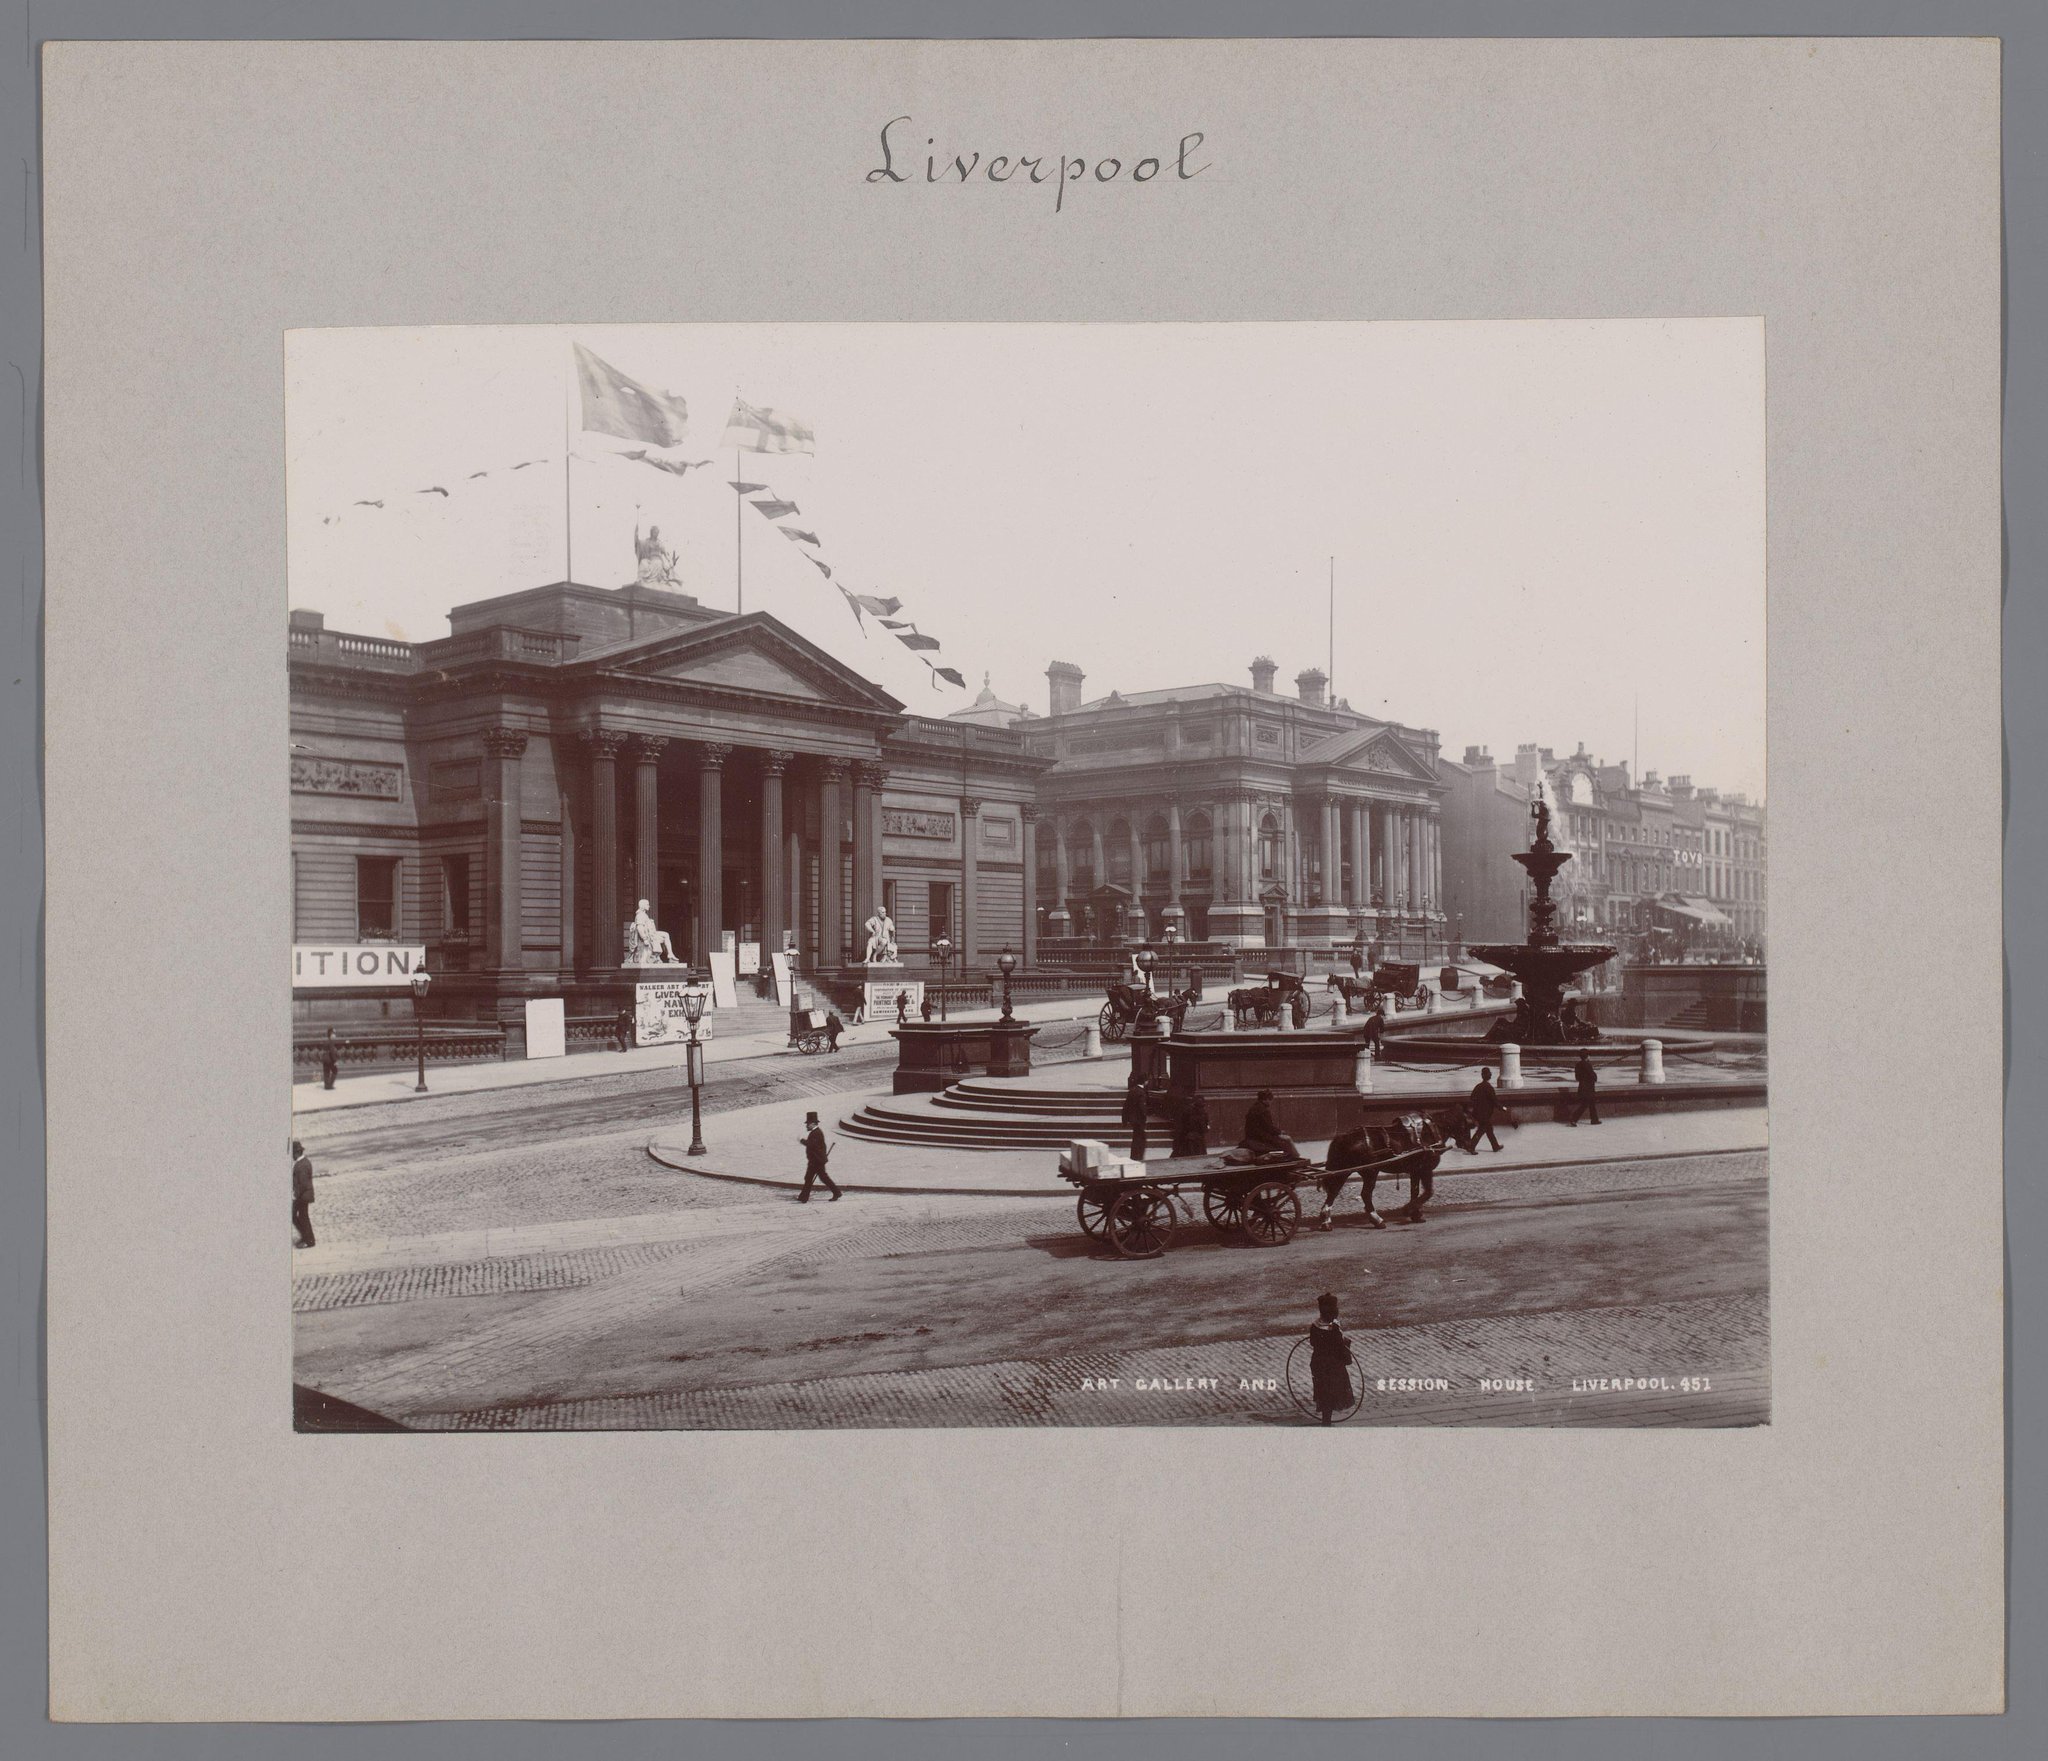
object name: photograph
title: Walker Art Gallery en Session House, William Brown Street, Liverpool, Engeland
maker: Anonymous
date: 1880-1910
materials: cardboard, paper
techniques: collodion silver print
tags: liverpool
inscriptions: inscription: ‘ART GALLERY AND SESSION HOUSE LIVERPOOL. 451’, inscription: ‘Liverpool’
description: Gezicht op een plein met fontein, links voor een classicistisch gebouw (Walker Art Gallery), daarnaast, meer rachts in de foto: County Sessions House.